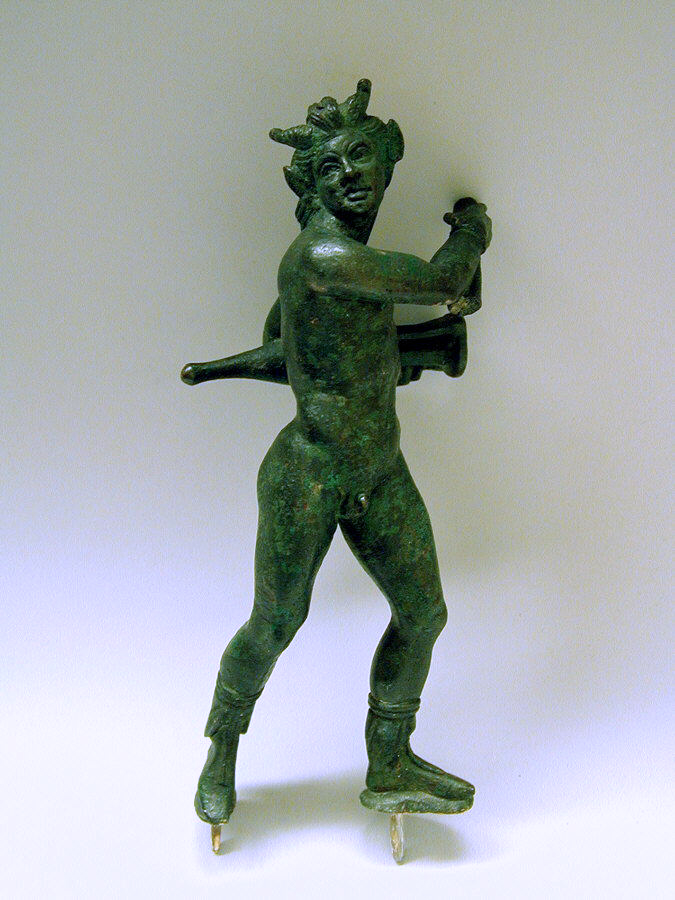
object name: statue of a satyr with an amphora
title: Bronze statuette of a satyr with an amphora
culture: roman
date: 1-100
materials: bronze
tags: satyrs